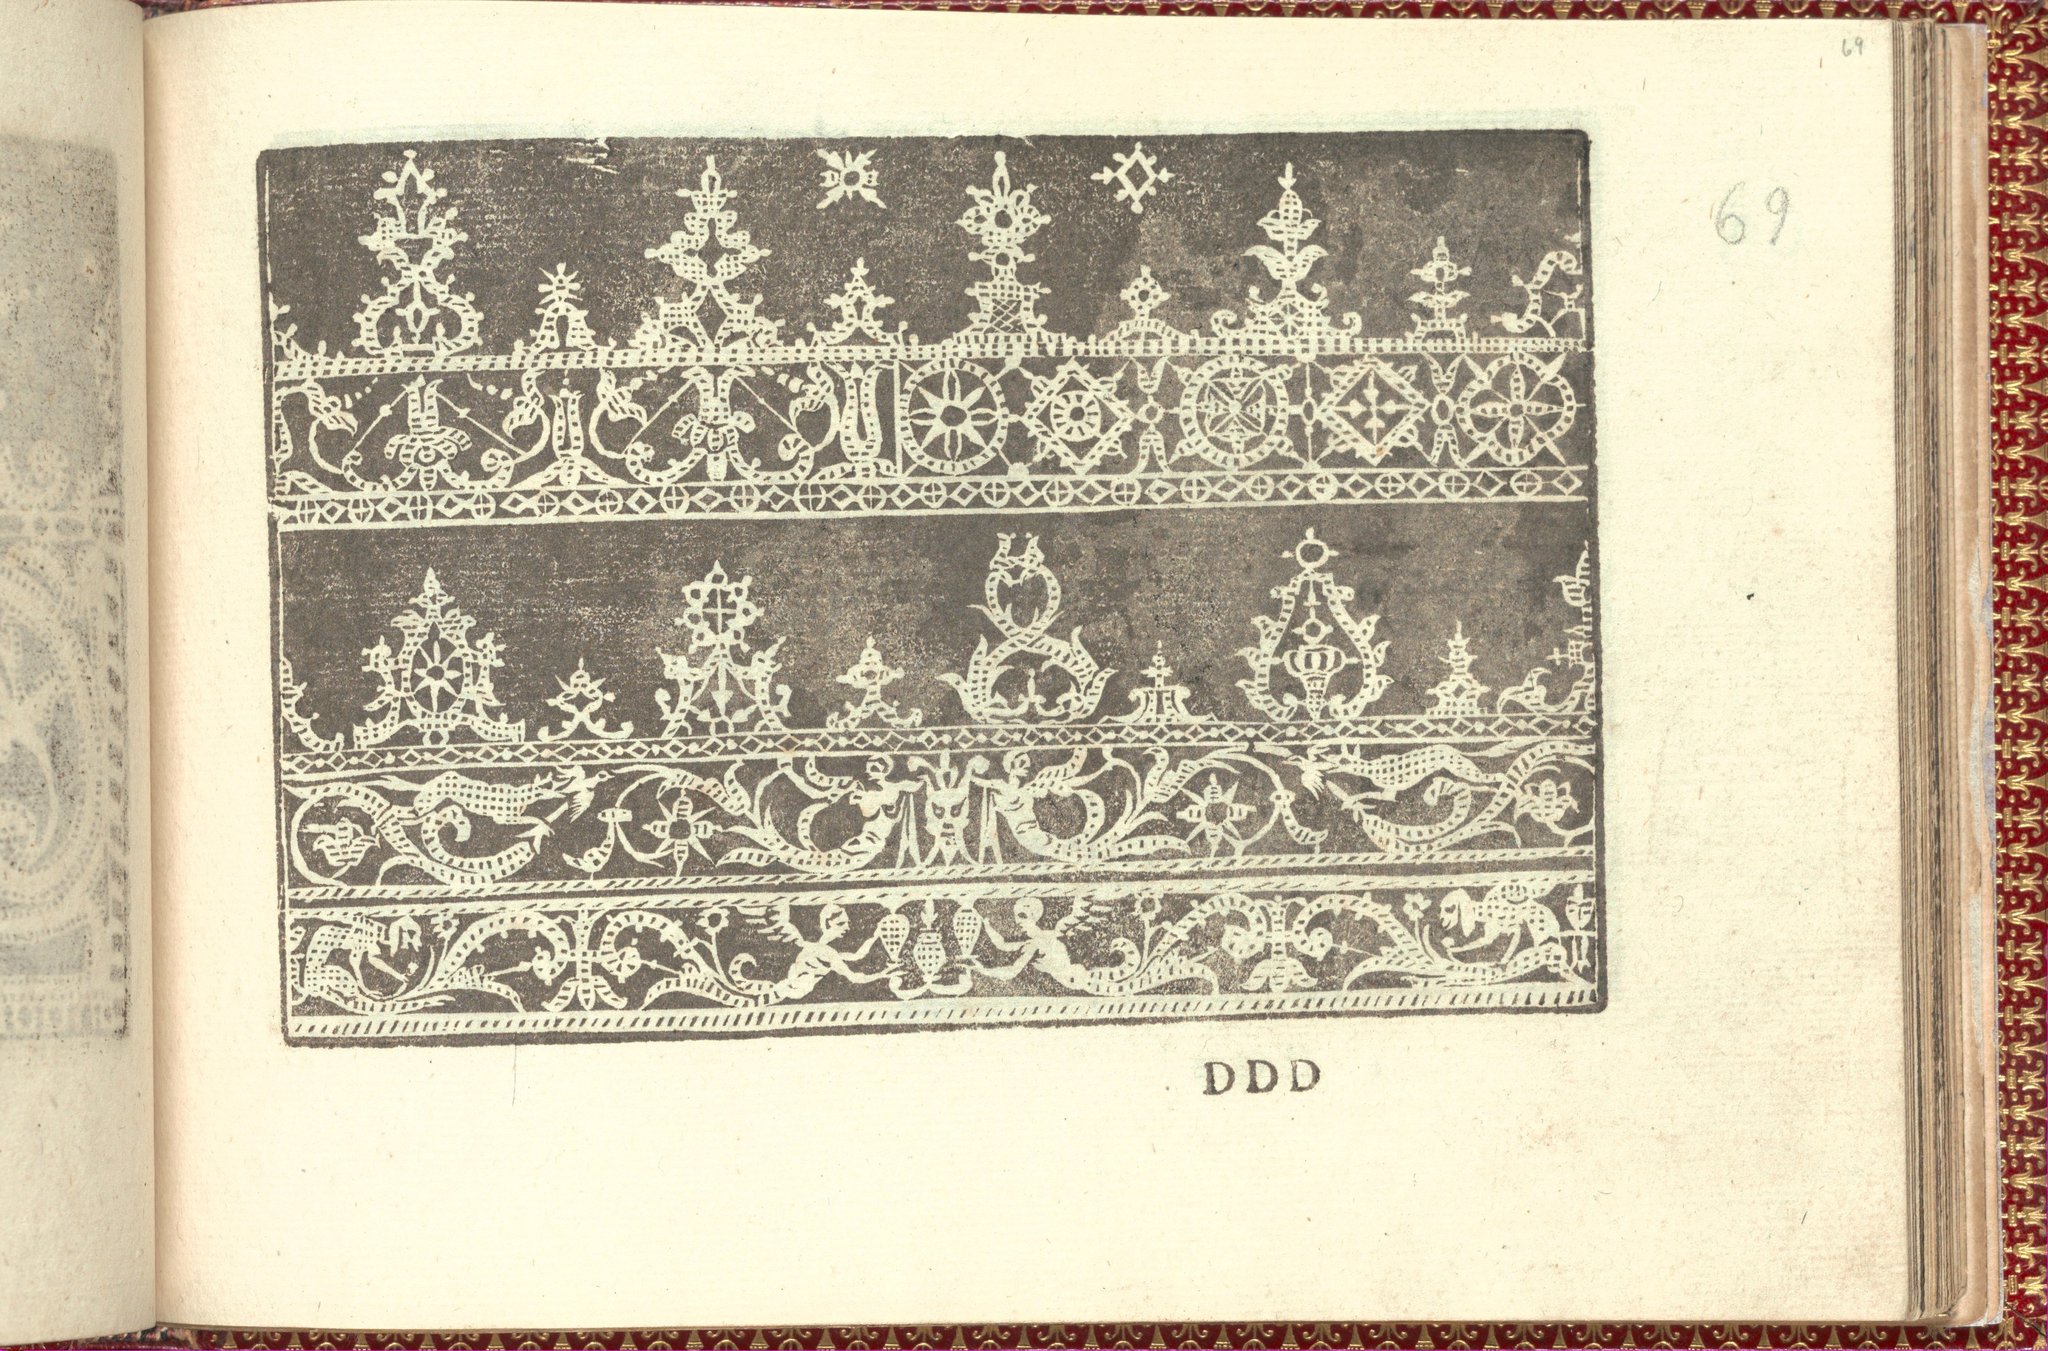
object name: book print ornament architecture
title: Corona delle Nobili et Virtuose Donne: Libro I-IV, page 69 (recto)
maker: cesare vecellio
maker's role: publisher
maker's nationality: italian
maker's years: 1521-1601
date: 1601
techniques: woodcut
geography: italy